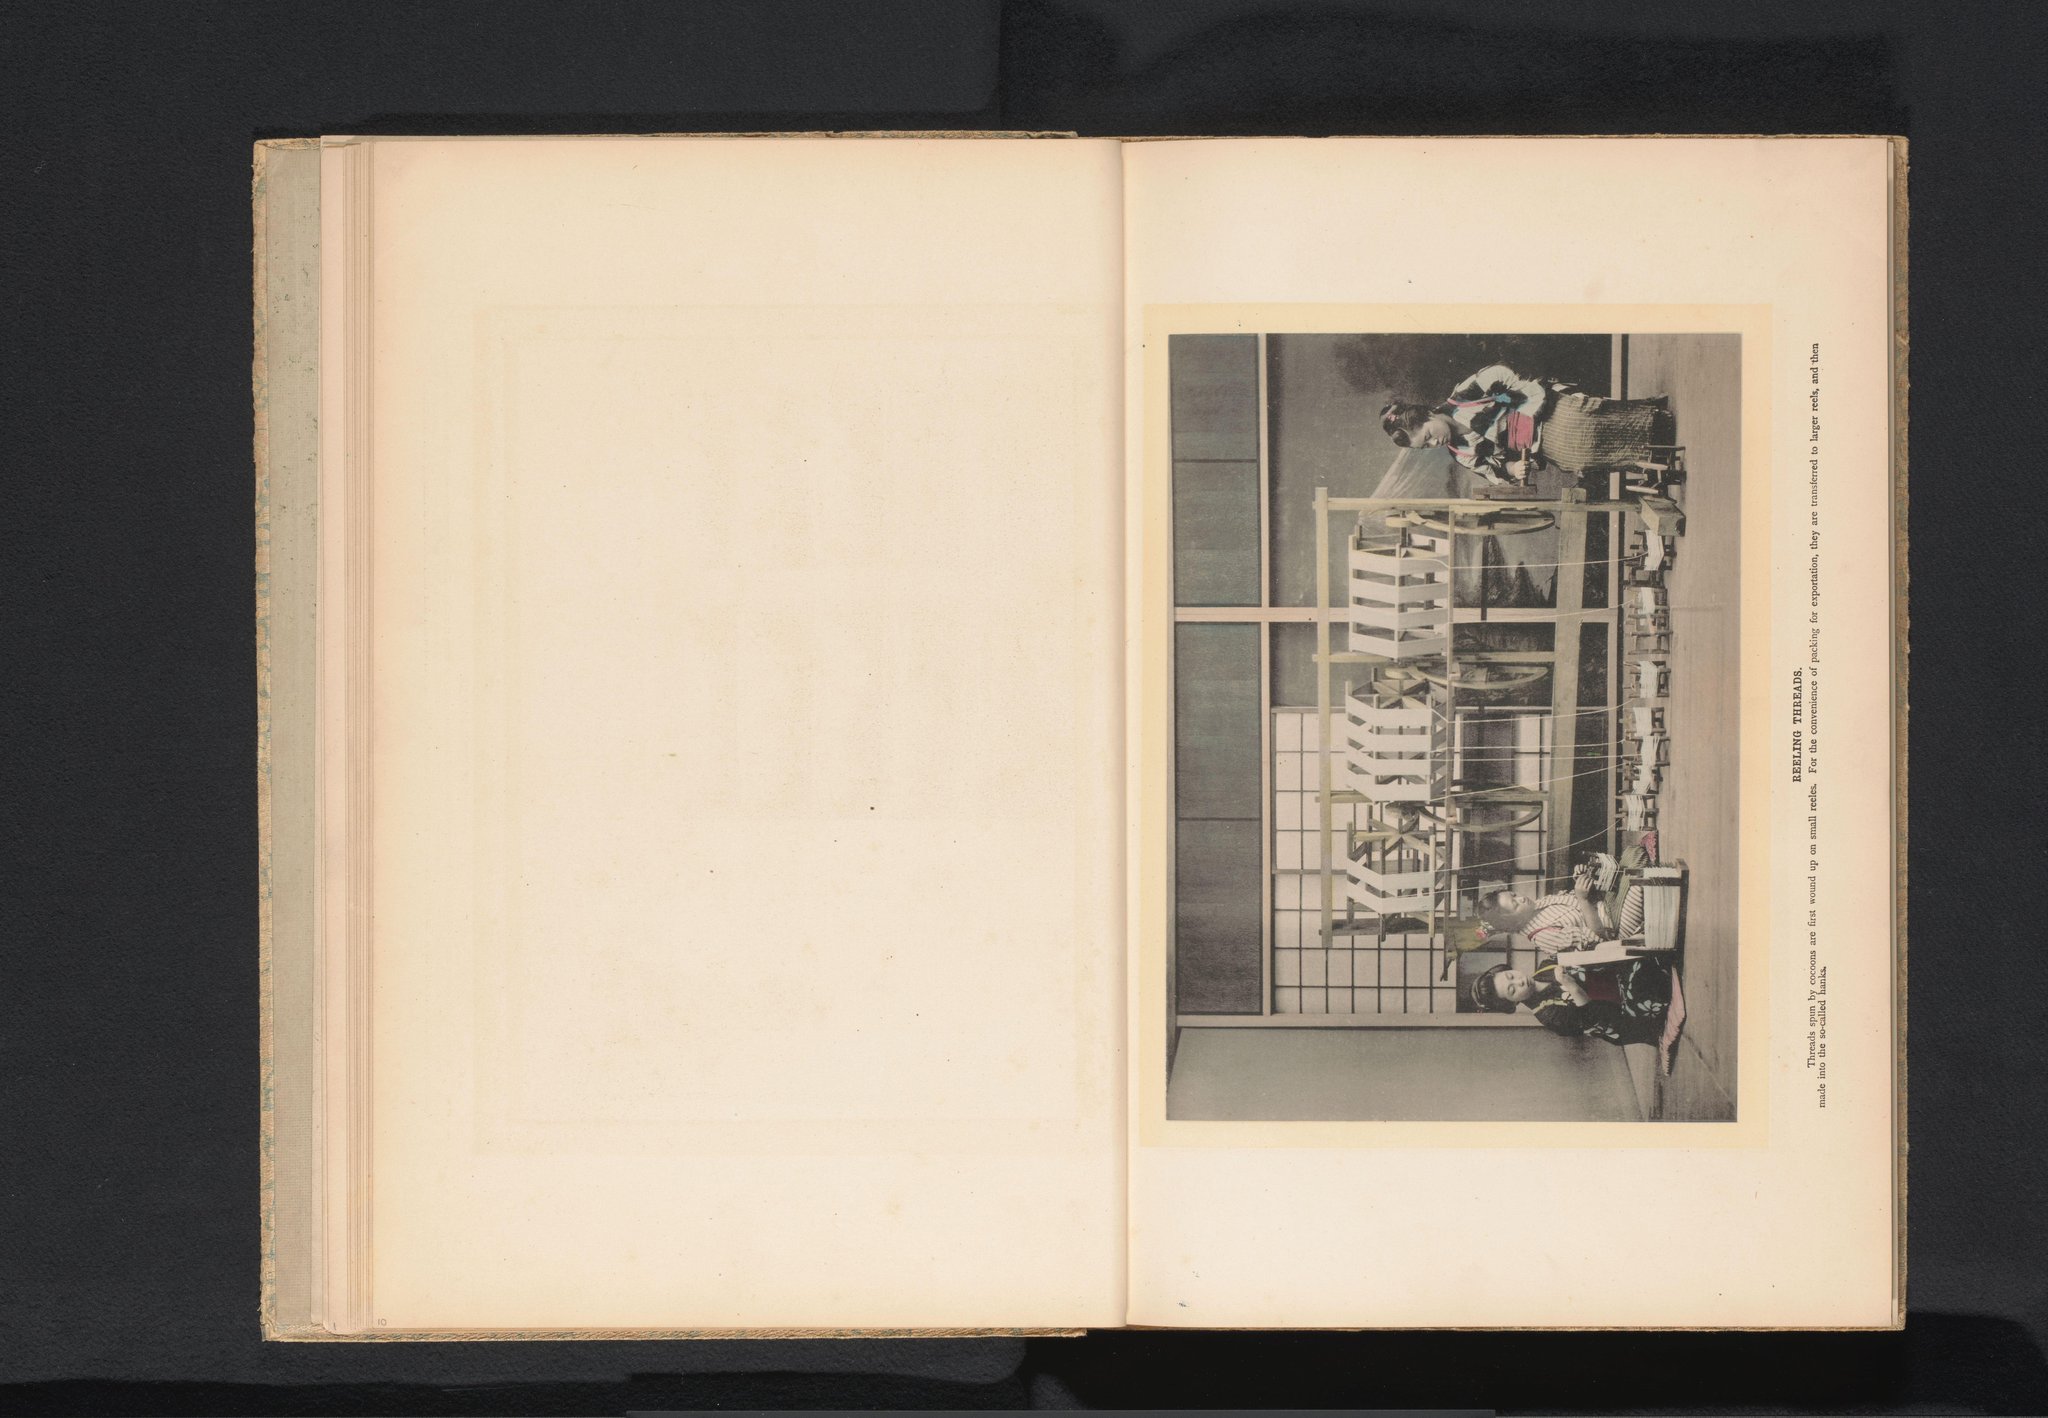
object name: photomechanical print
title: Reeling Threads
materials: paper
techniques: photograph, lithograph, hand coloring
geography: tokyo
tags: weaving-loom (+ women (labourers)), japan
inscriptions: inscription: ‘Threads spun (...) so-called hanks.’